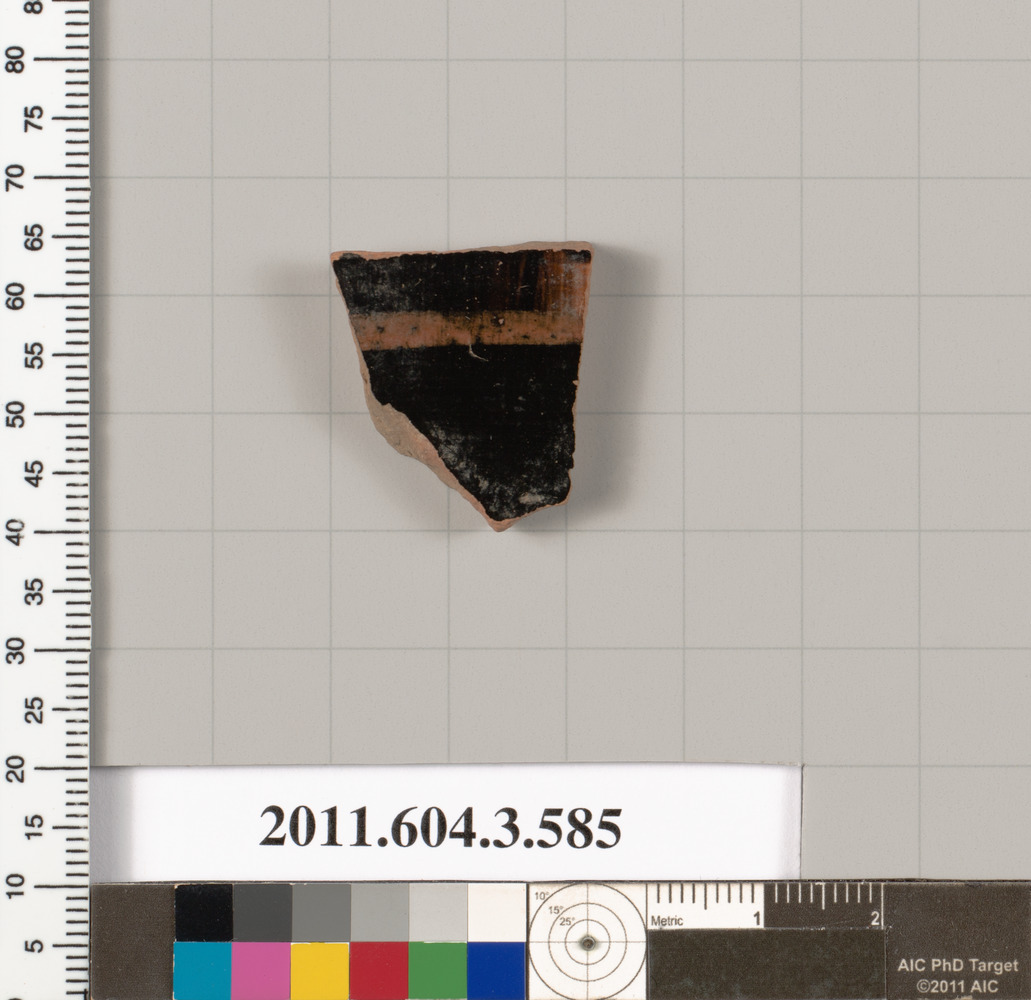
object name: column krater fragment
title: Terracotta fragment of a column-krater (bowl for mixing wine and water)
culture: greek, attic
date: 600-401 BCE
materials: terracotta